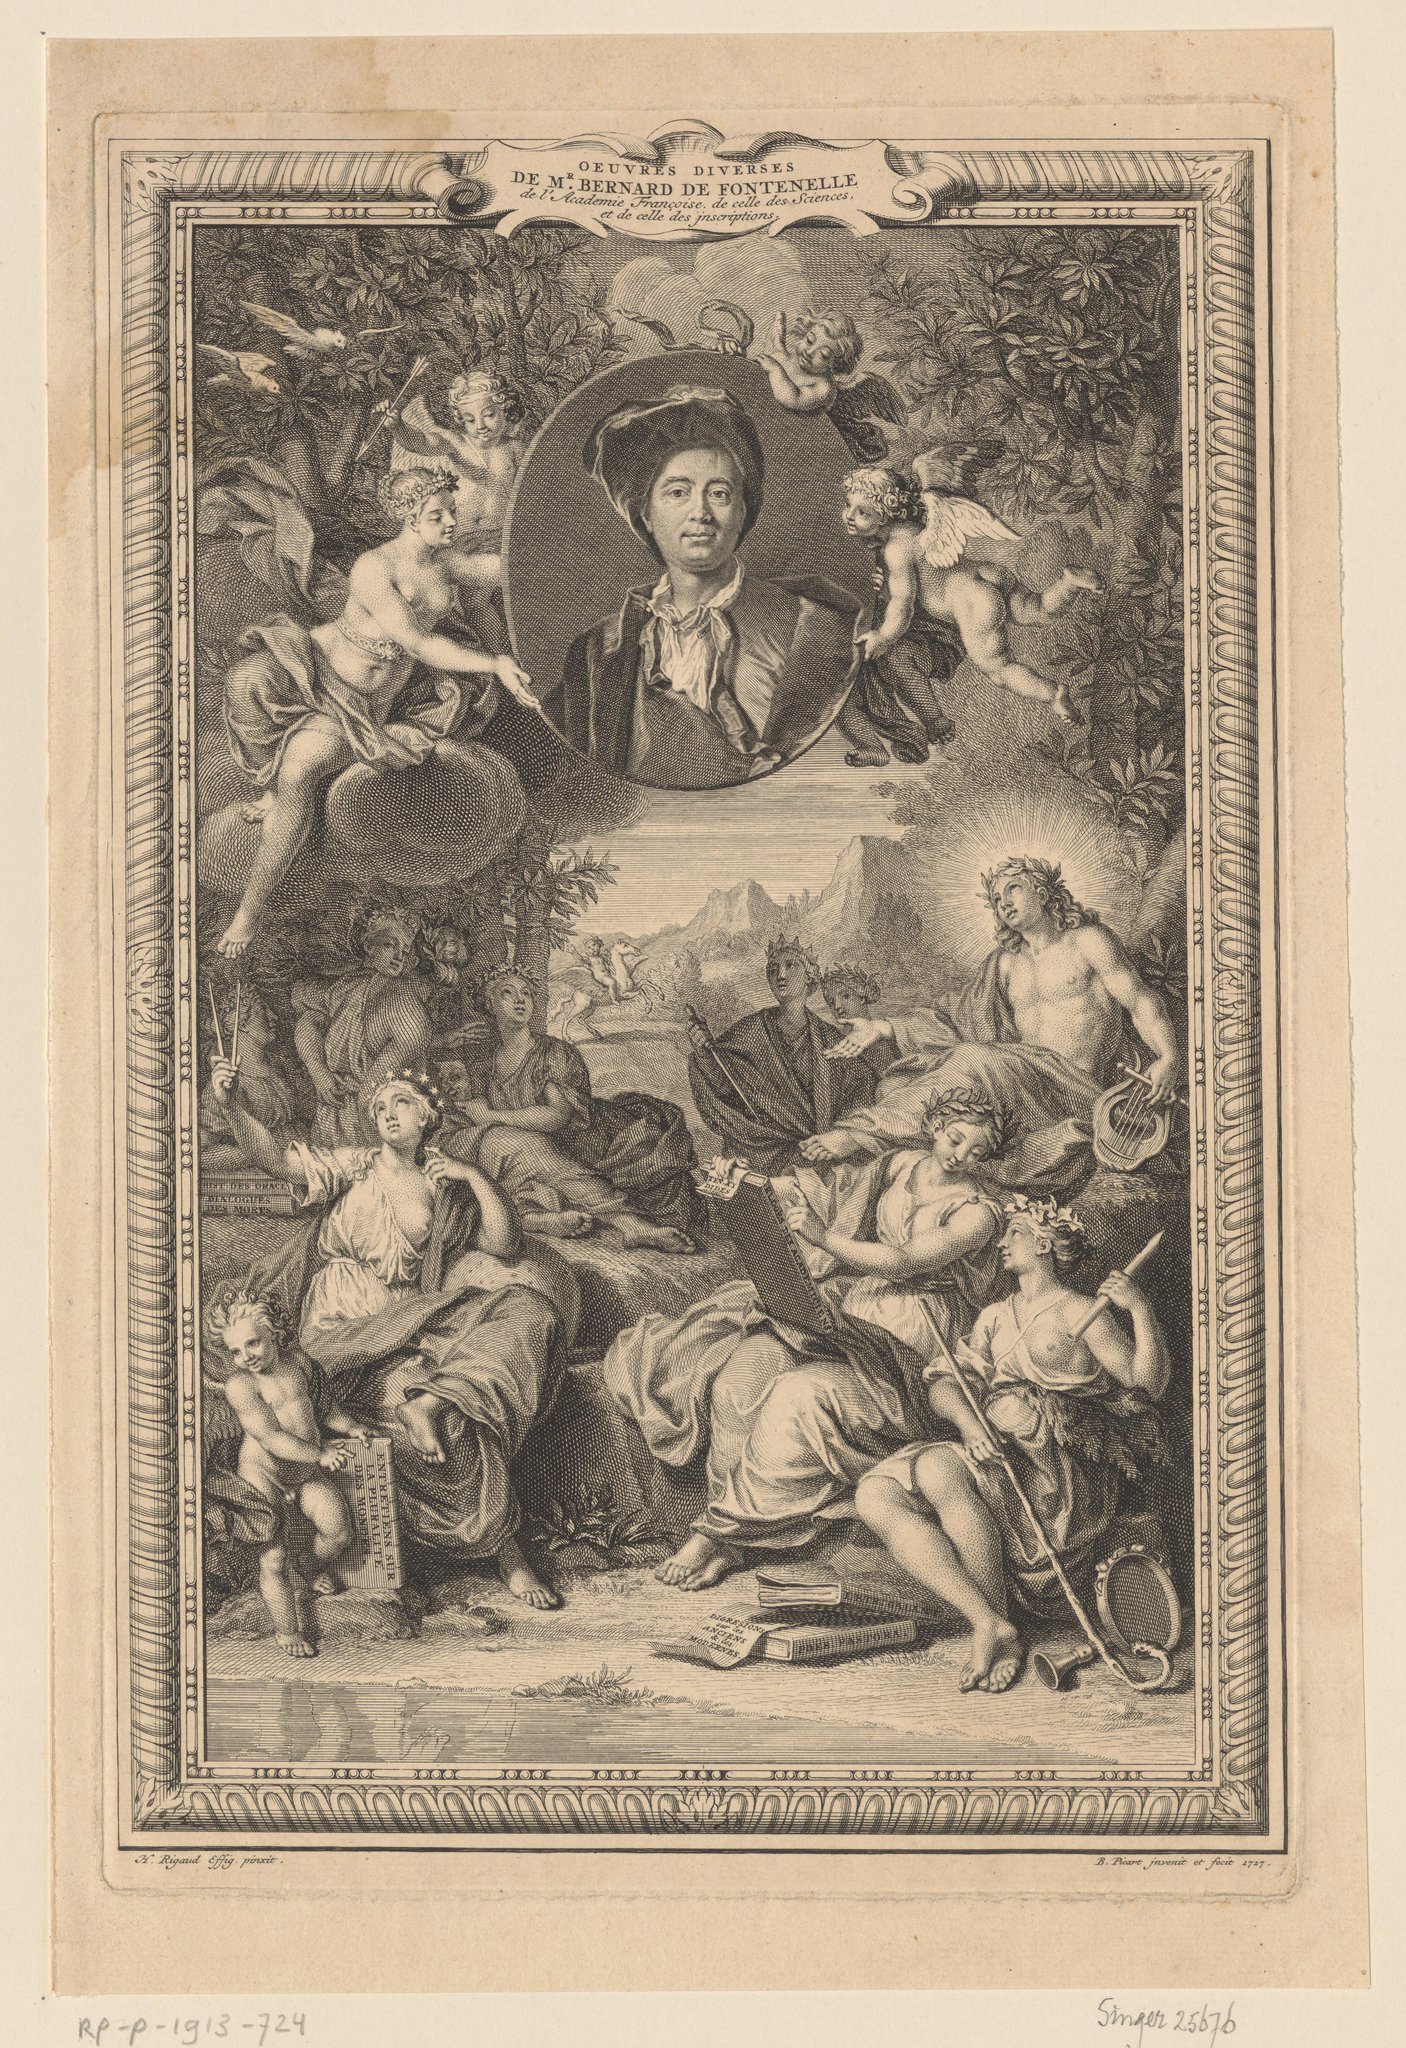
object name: titelblad, titelpagina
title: Titelpagina voor: Bernard de Fontenelle, Oeuvres diverses de Mr. Bernard de Fontenelle, 1728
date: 1727-1728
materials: paper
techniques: engraving, etching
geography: amsterdam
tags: paris, the liberal arts, 'artes liberales', historical persons, portrait of a writer, cupids: 'amores', 'amoretti', 'putti'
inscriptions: collector's mark: Lugt 2233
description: Landschap met de vrouwelijke personificaties van de zeven vrije kunsten. Boven hen vliegen putti die het portret van de schrijver Bernard de Fontenelle dragen. Op de achtergrond een putto op de rug van Pegasus. De voorstelling is gevat in een omlijsting die wordt bekroond door een cartouche waarin de titel in het Frans staat.